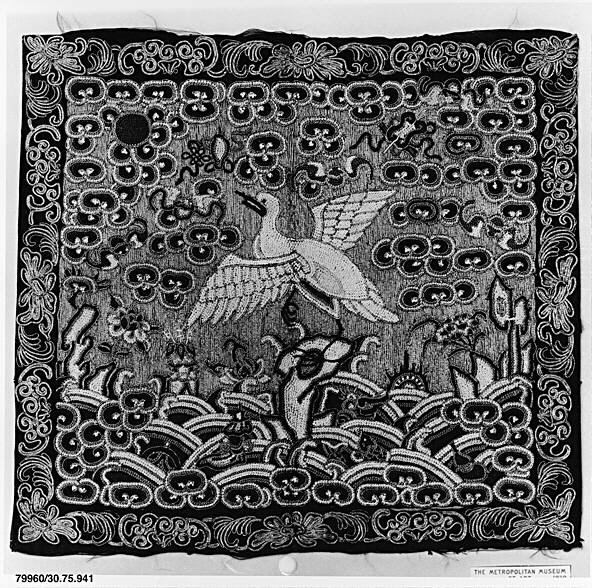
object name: rank badge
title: Rank Badge with Wild Goose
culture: chinese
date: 1767-1833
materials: metal thread, silk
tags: geese